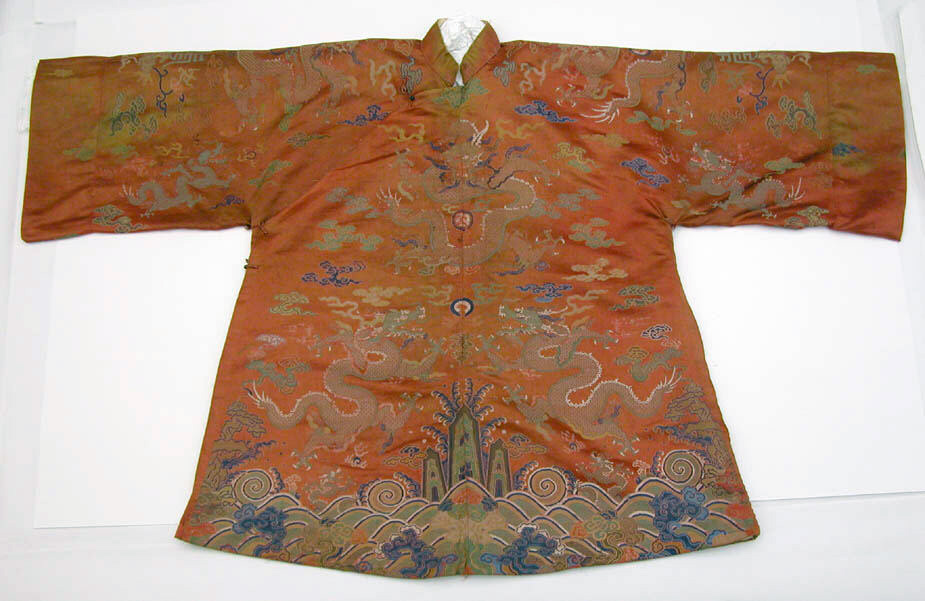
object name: coat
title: Short Coat for Image (?)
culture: chinese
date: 1667-1733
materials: silk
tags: dragons